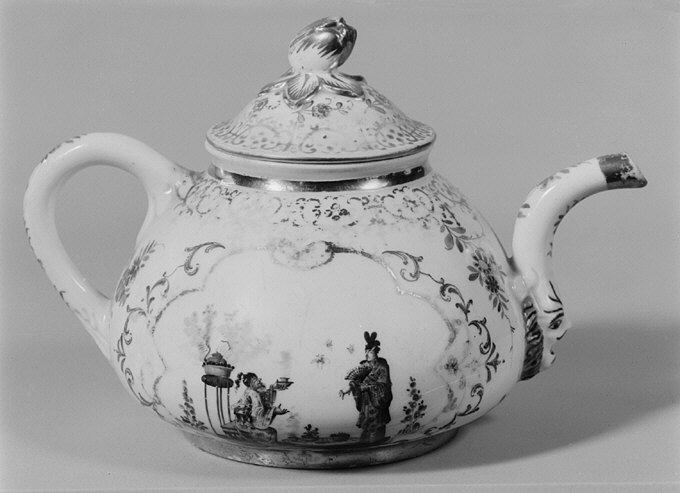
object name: teapot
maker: meissen manufactory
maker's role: manufactory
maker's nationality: german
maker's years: 1710-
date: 1725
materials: hard paste porcelain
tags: human figures